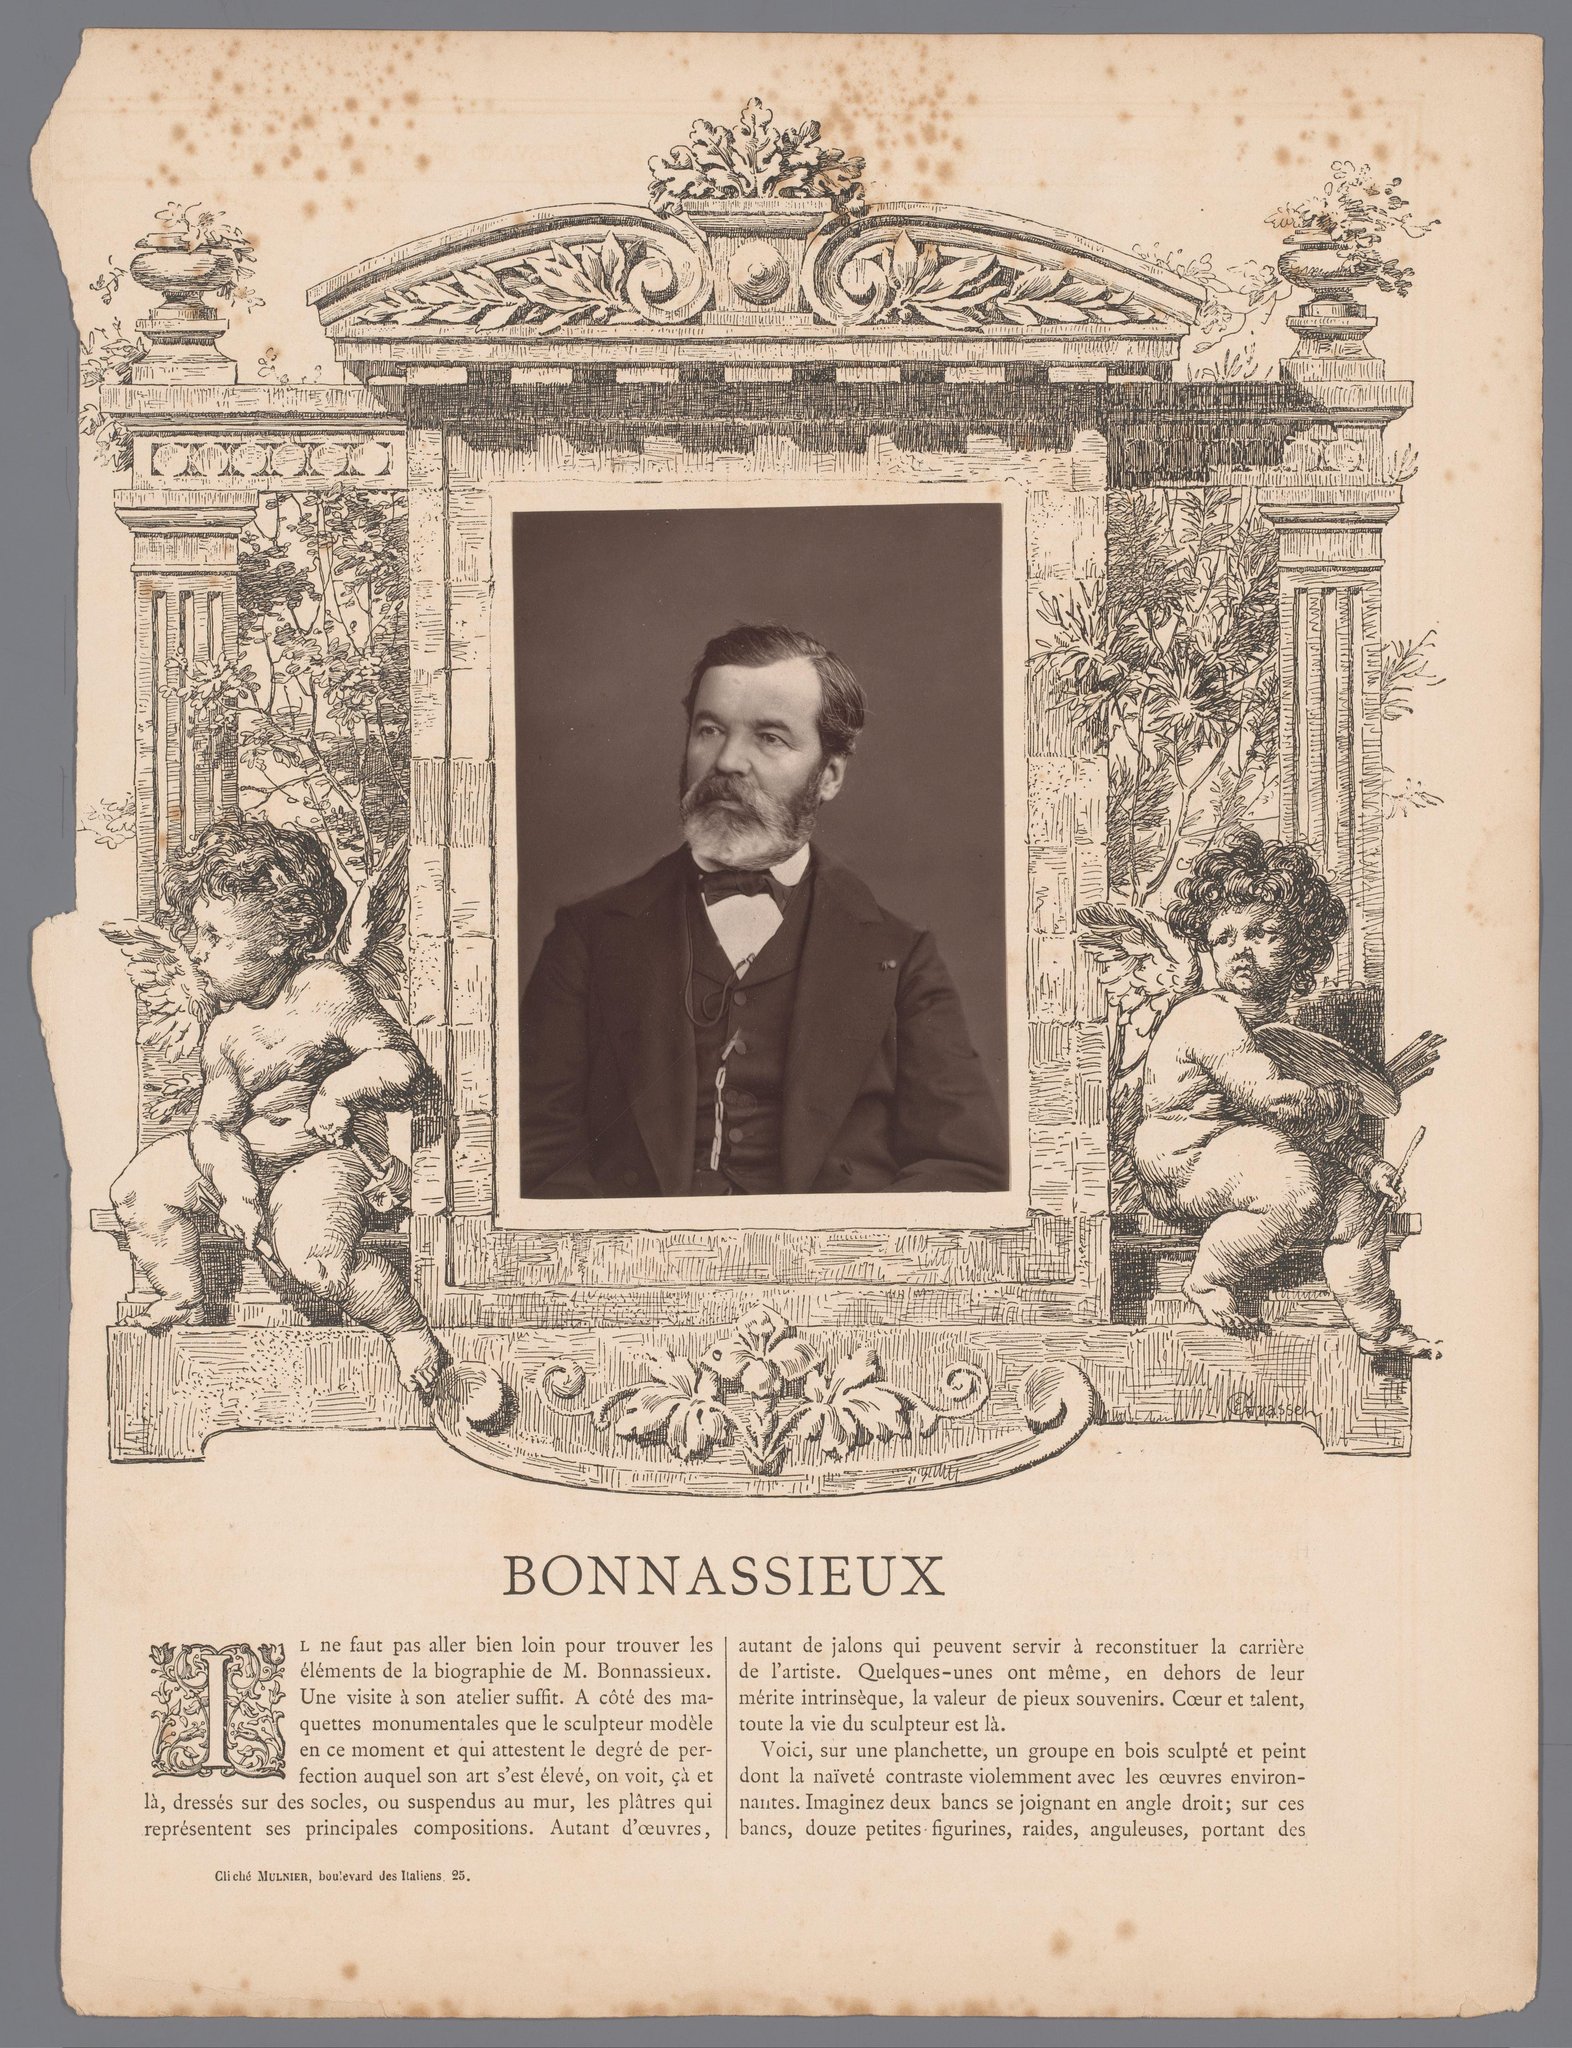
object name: photograph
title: Portret van Jean-Marie Bonnassieux (1810-1892), Frans beeldhouwer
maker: mulnier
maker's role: fotograaf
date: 1870-1900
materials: cardboard, photographic support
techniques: carbon print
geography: paris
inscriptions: number: ‘AKIV6//1310.’, inscription: ‘Mulnier Carbonprint 1870's’, inscription: ‘BONNASSIEUX’, inscription: ‘Cliché MULNIER, boulevard des Italiens, 25.’, inscription